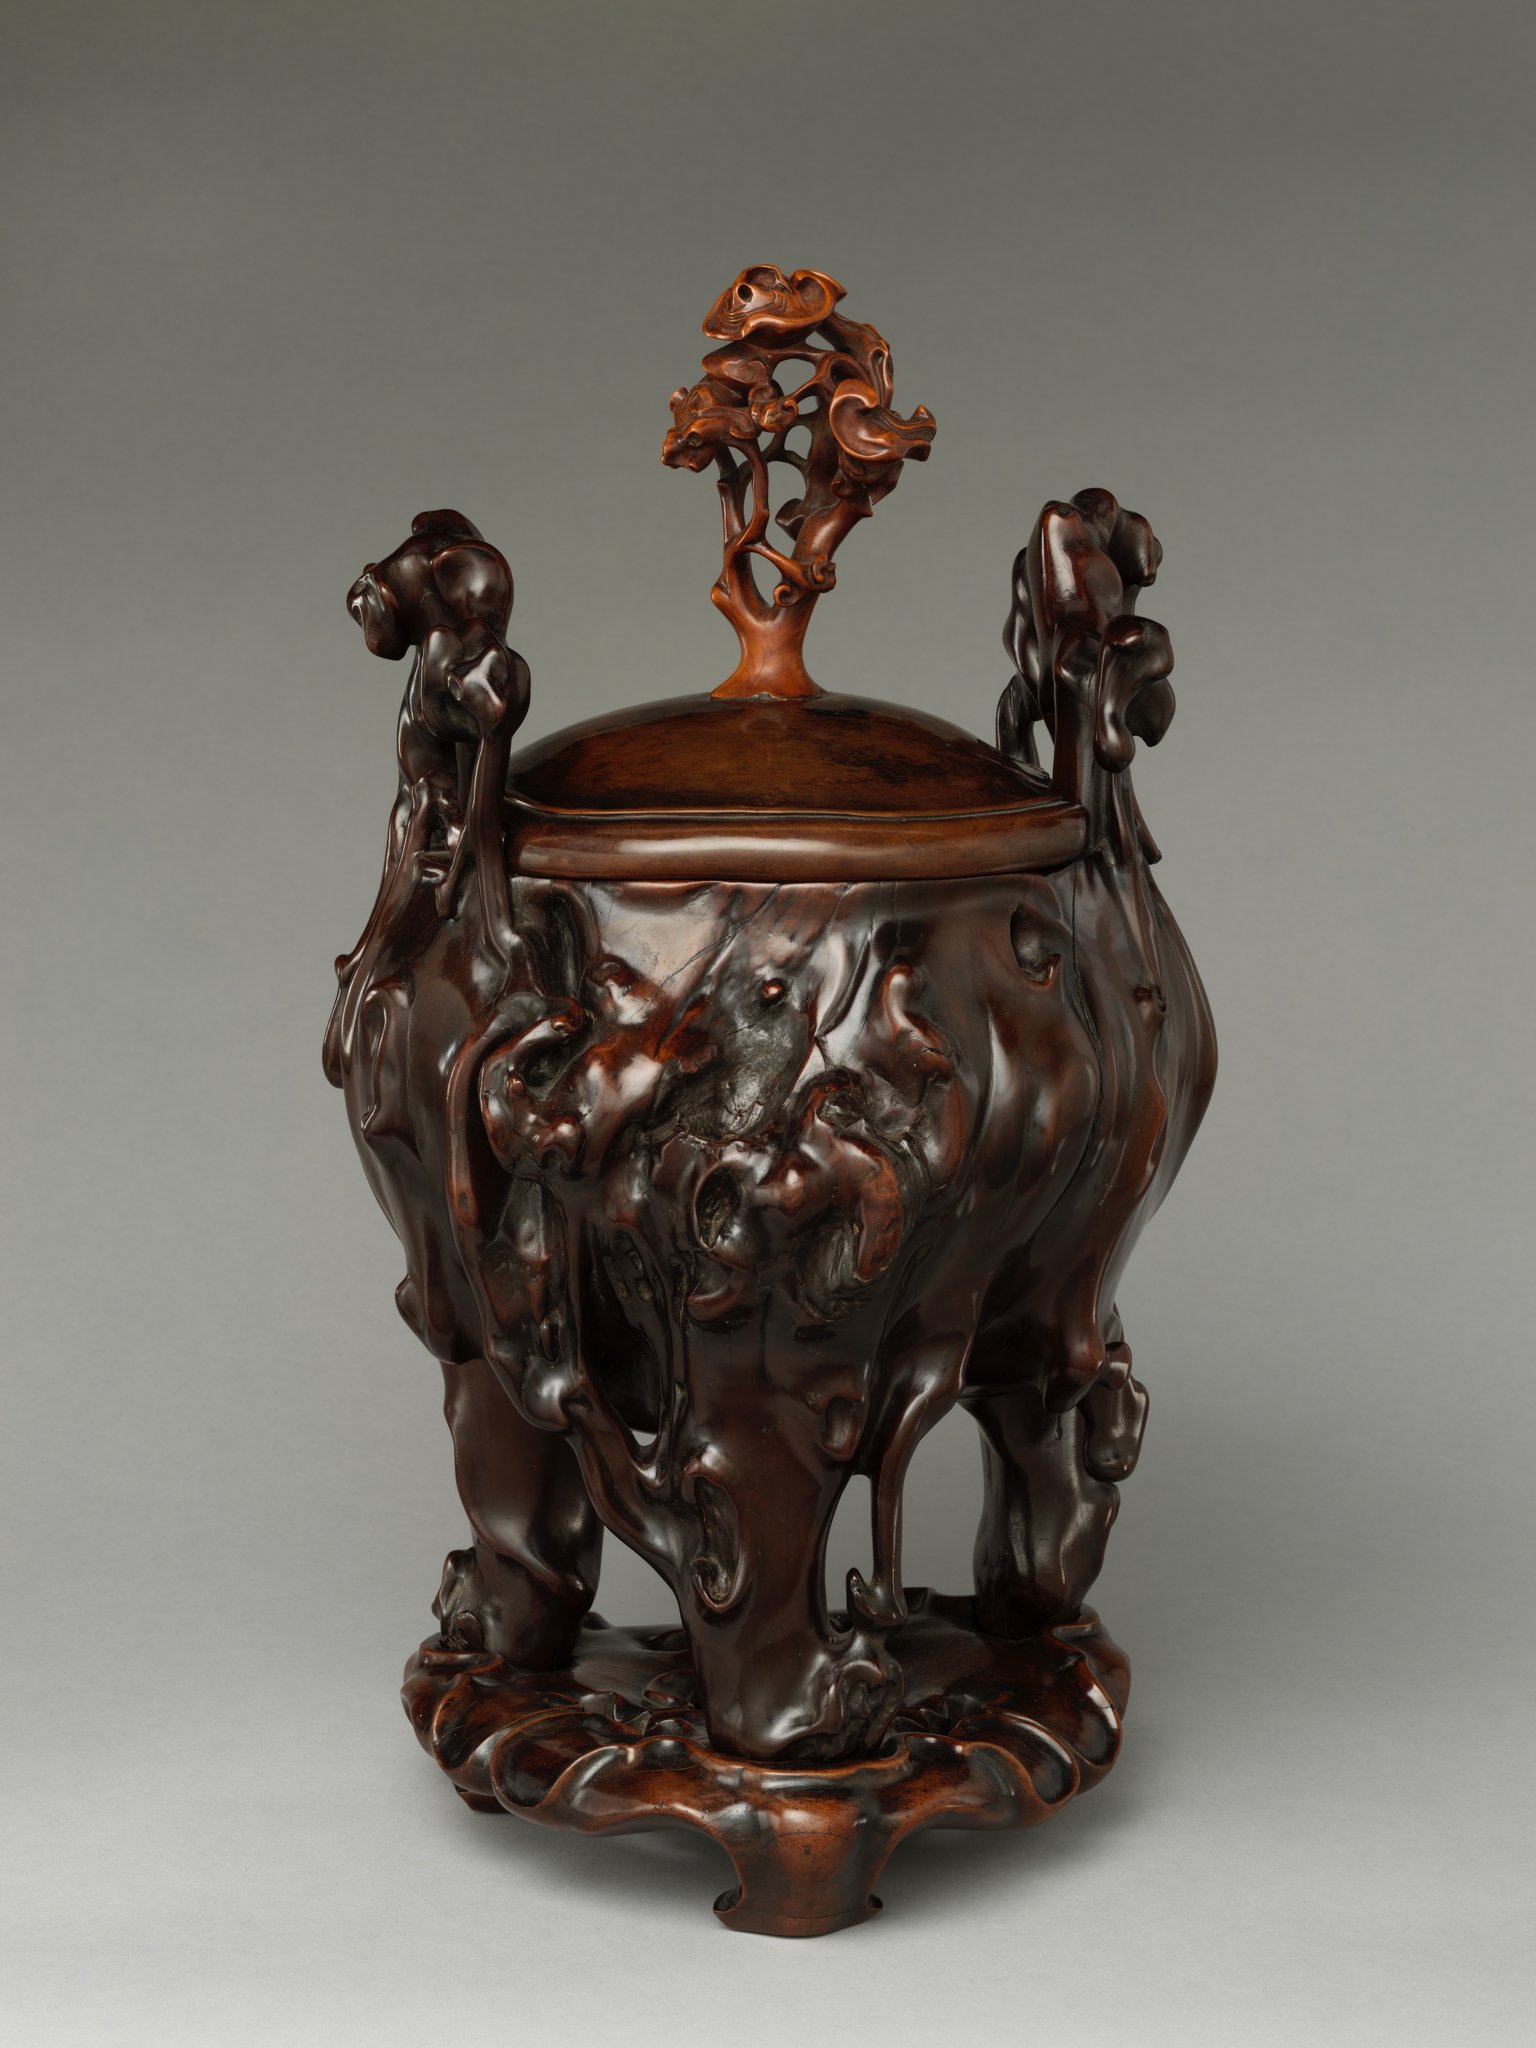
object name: censer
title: Incense burner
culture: chinese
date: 1767-1800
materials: wood